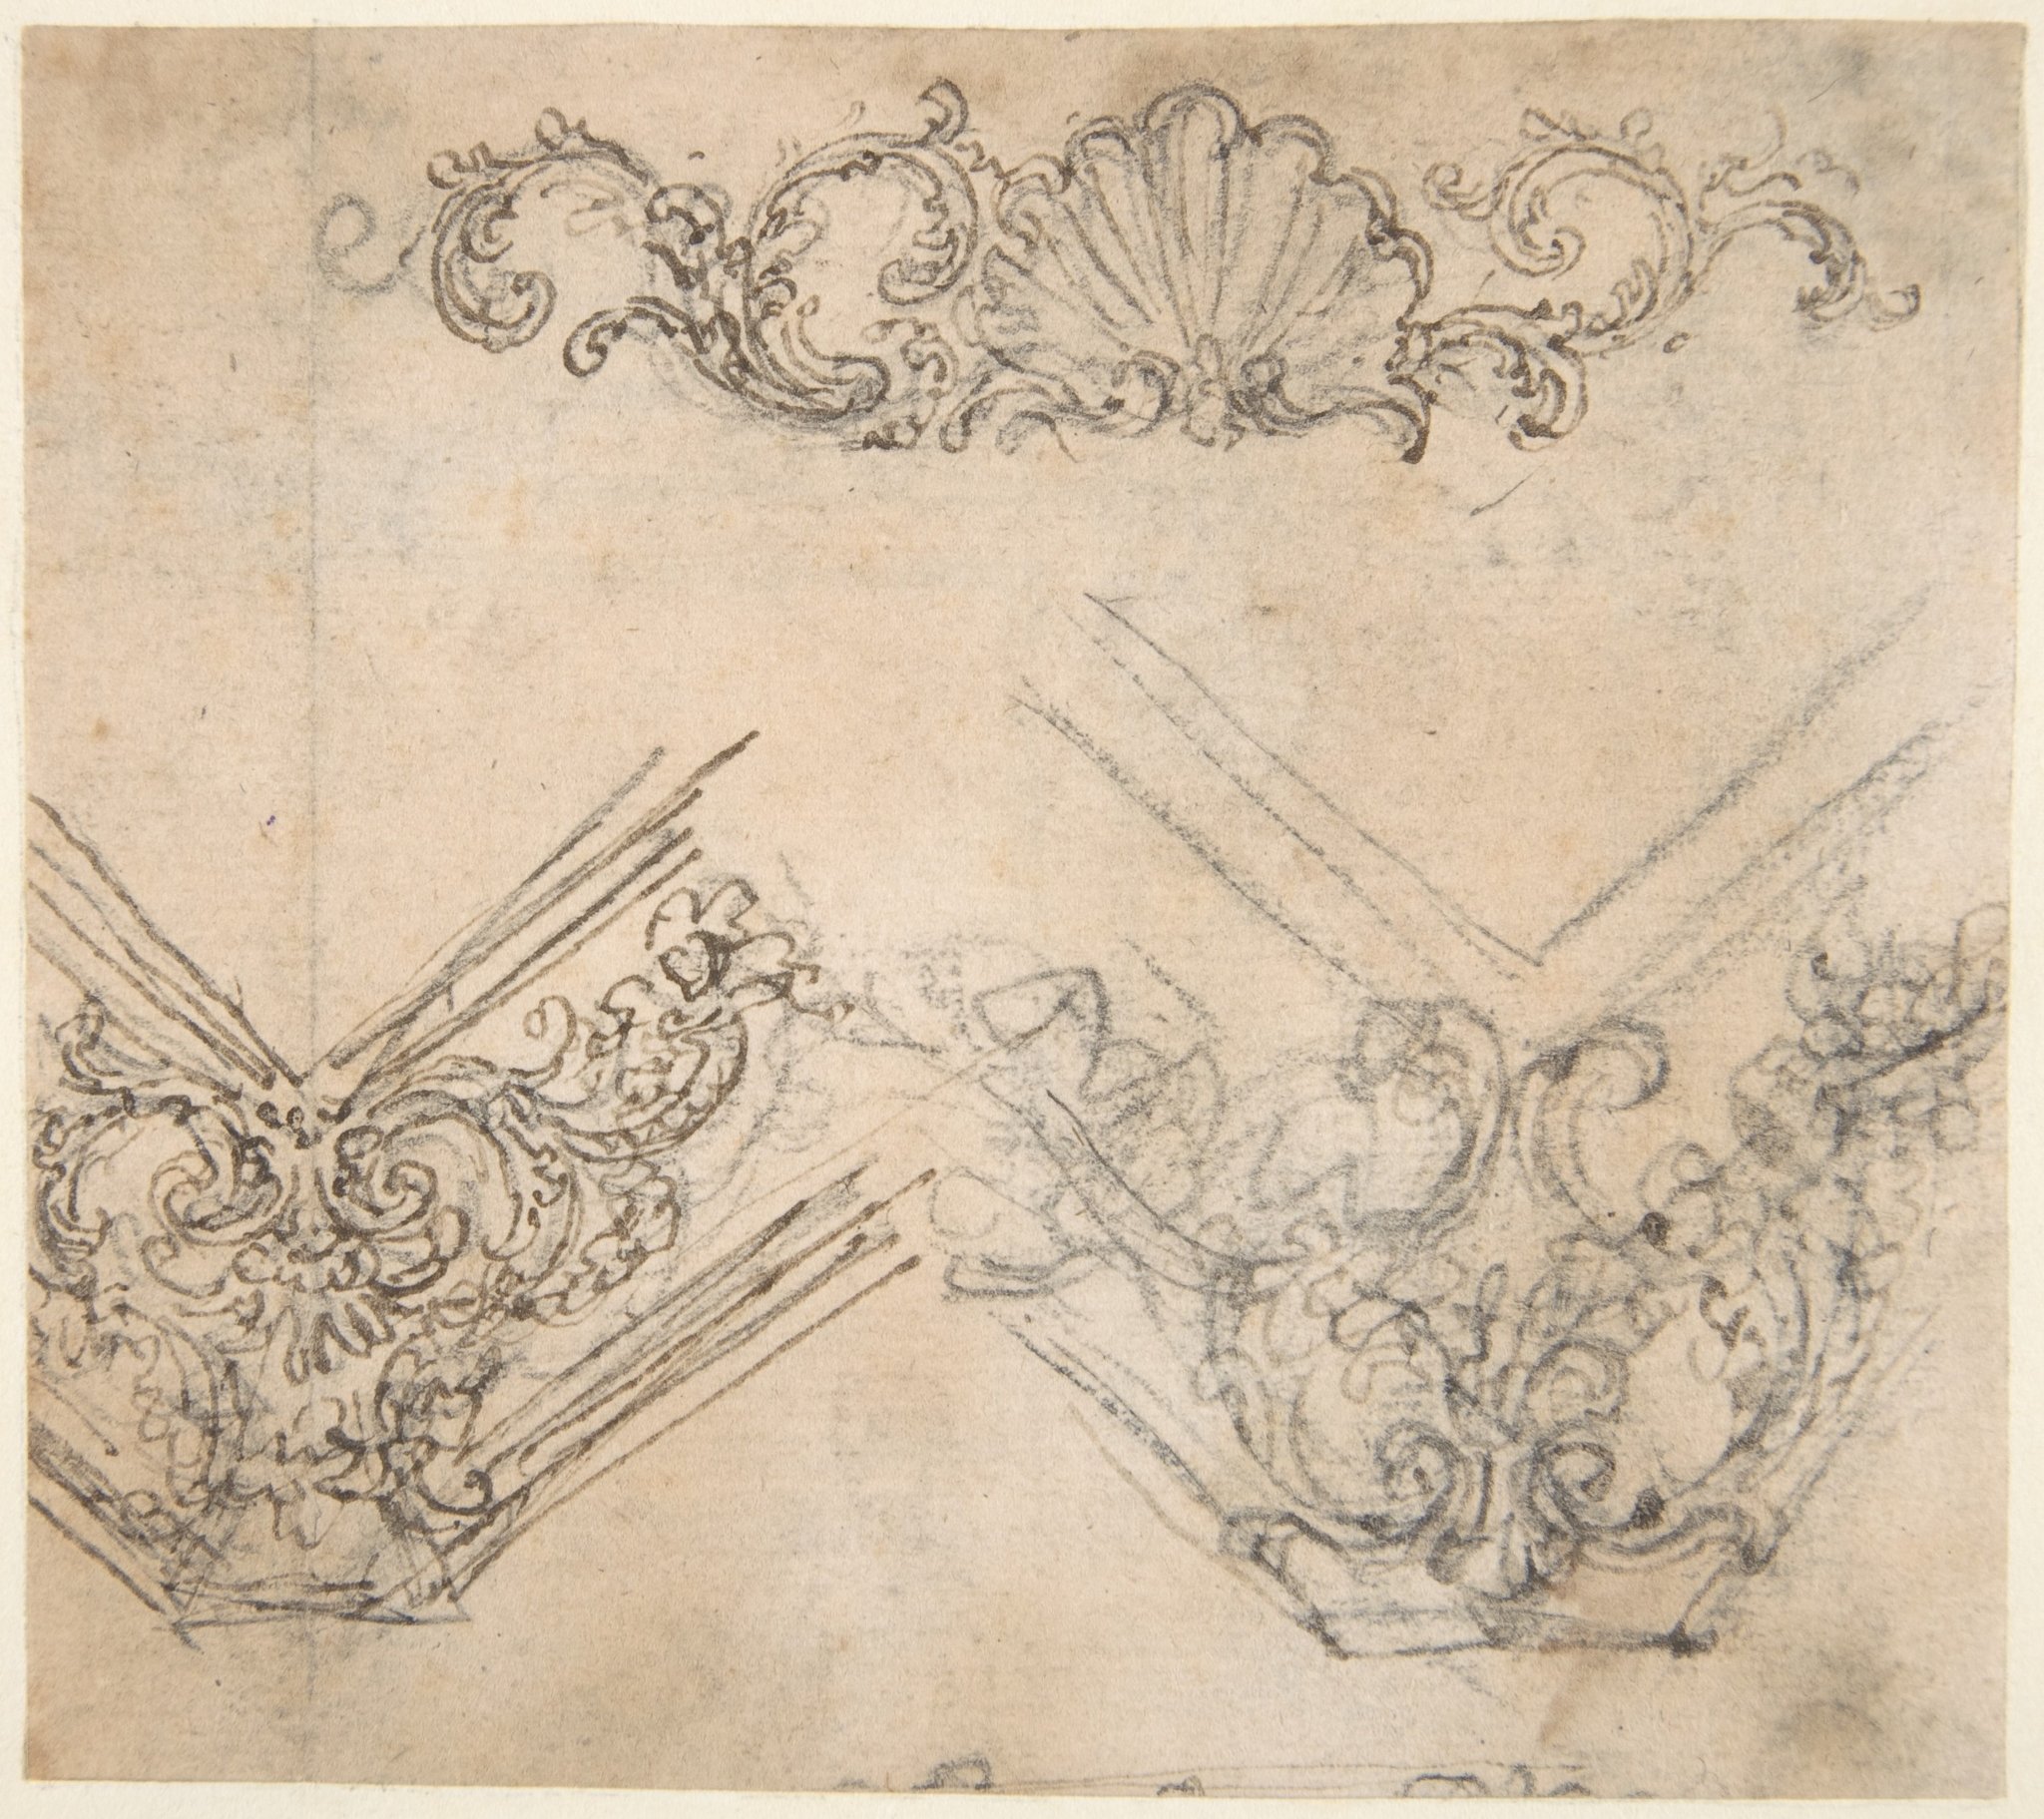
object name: drawing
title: Designs for the Decoration of a Frieze and Corner Motifs (recto); Design for Two Frames Decorated with Volutes, Garlands and the Head of a Putto (verso)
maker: giovanni battista foggini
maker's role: artist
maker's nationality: italian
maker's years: 1652-1725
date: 1672-1725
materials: chalk, ink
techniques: pen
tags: ornament